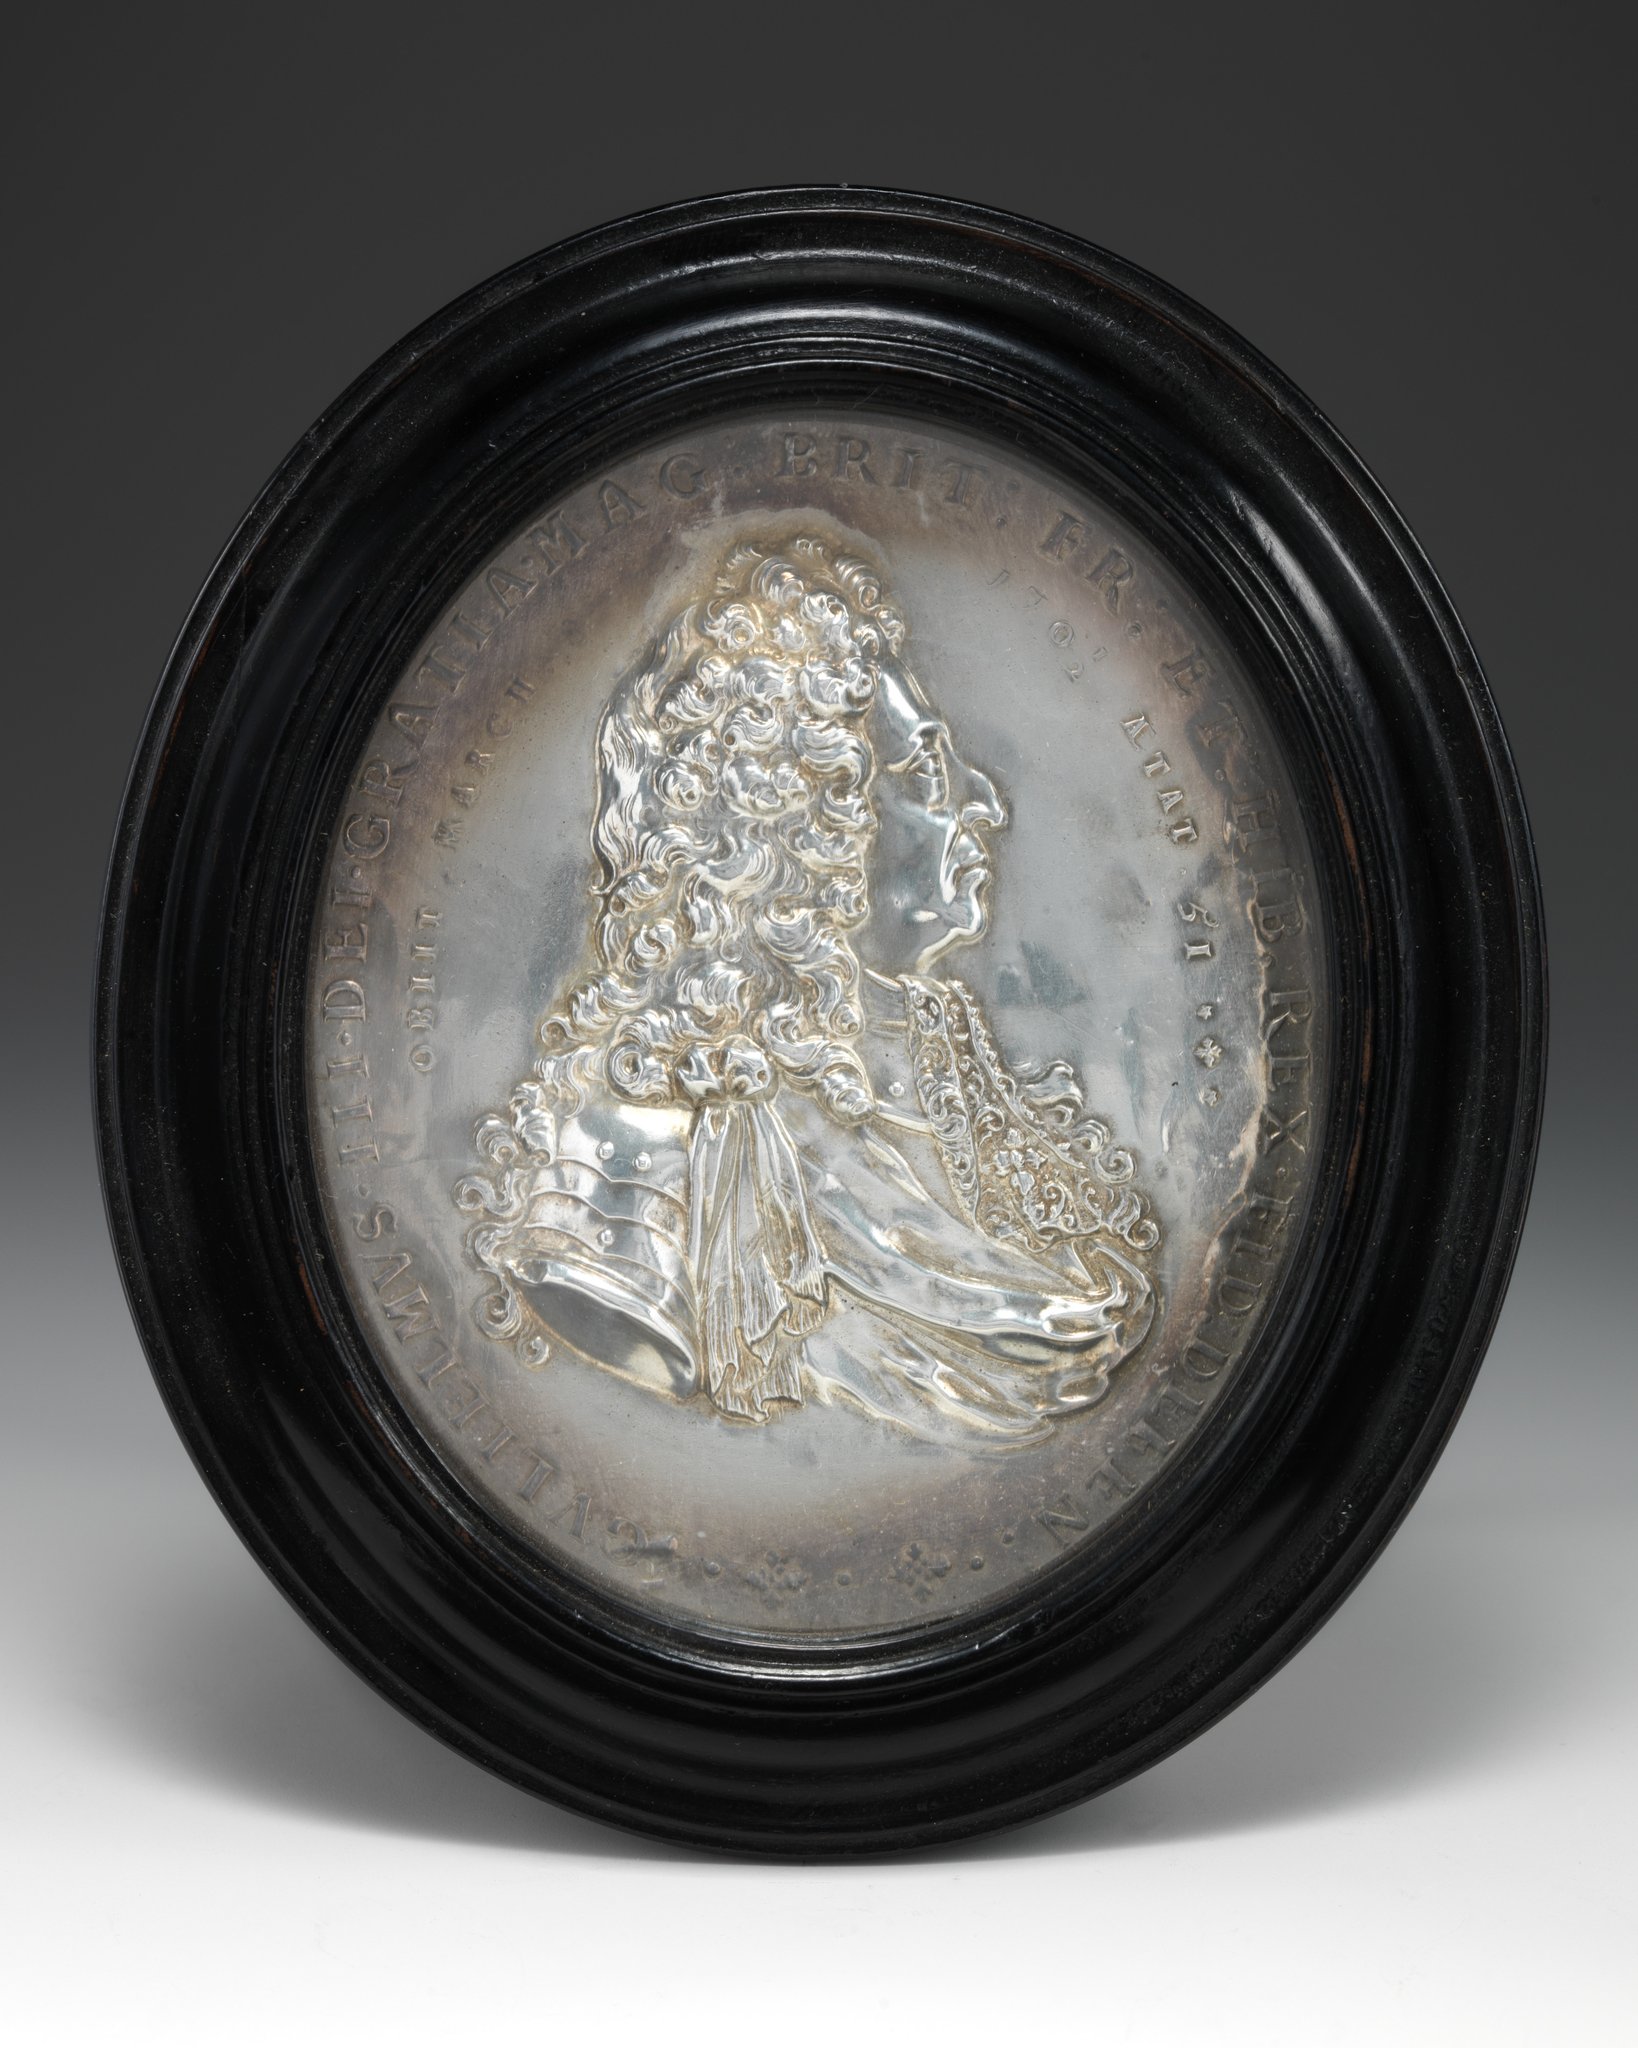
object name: plaquette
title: William III, King of England (1650–1702)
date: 1701-1800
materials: silver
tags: kings,profiles